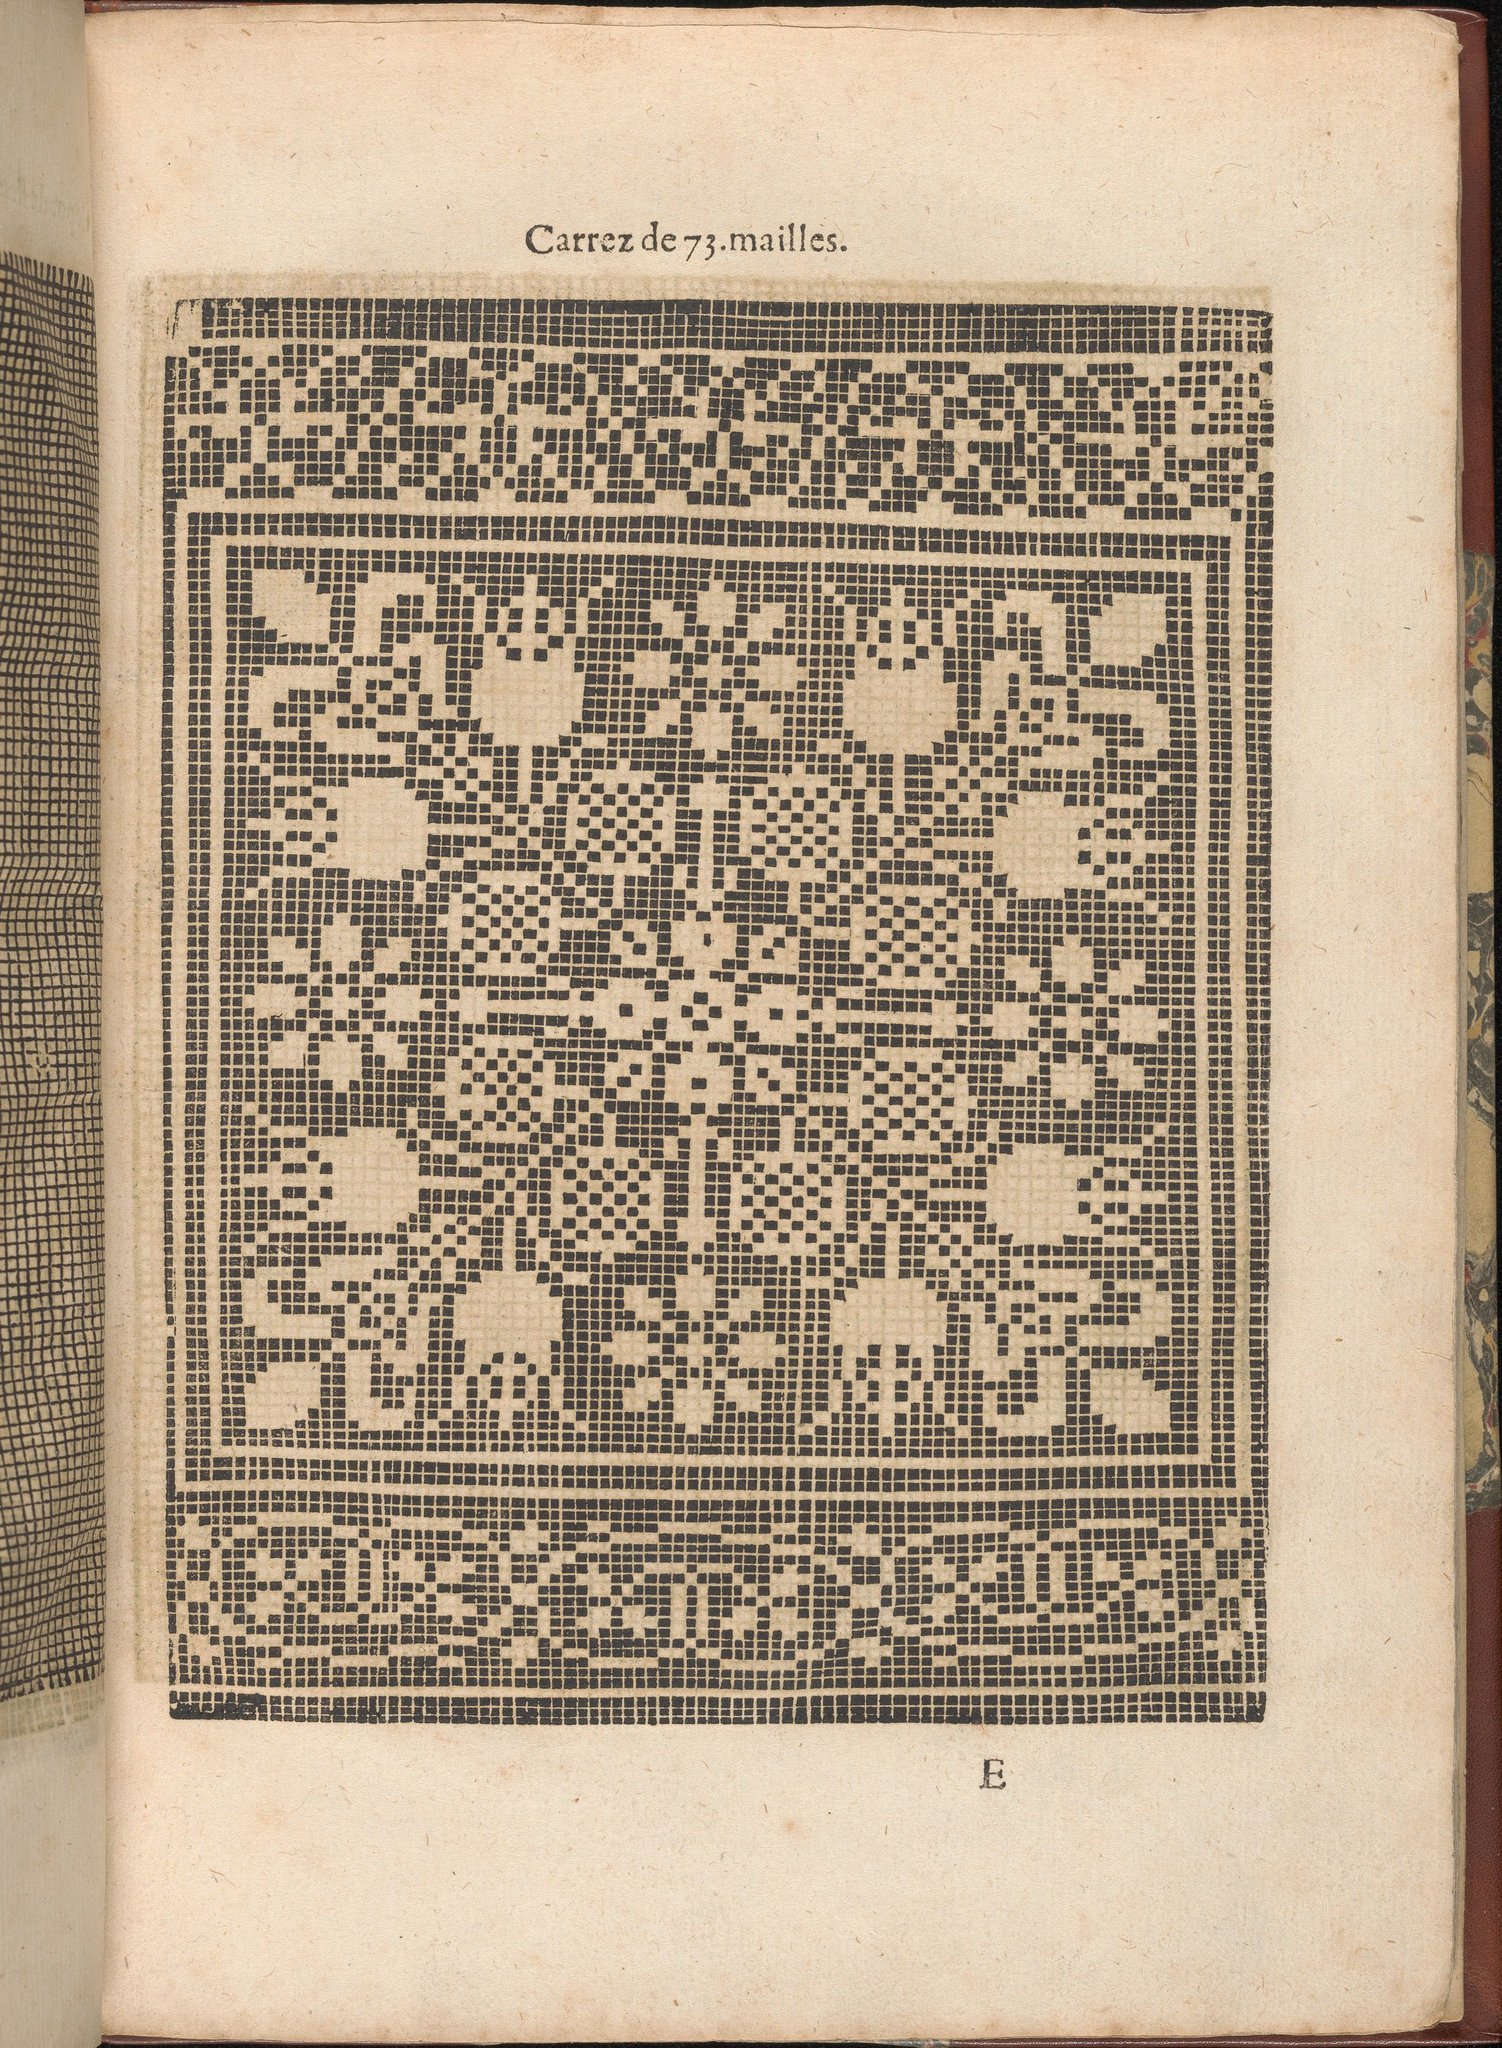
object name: book print ornament architecture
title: Les Secondes Oeuvres, et Subtiles Inventions De Lingerie du Seigneur Federic de Vinciolo Venitien, page 17 (recto)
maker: federico de vinciolo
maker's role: designer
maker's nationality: italian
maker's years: 1582-1599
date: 1603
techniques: woodcut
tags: flowers